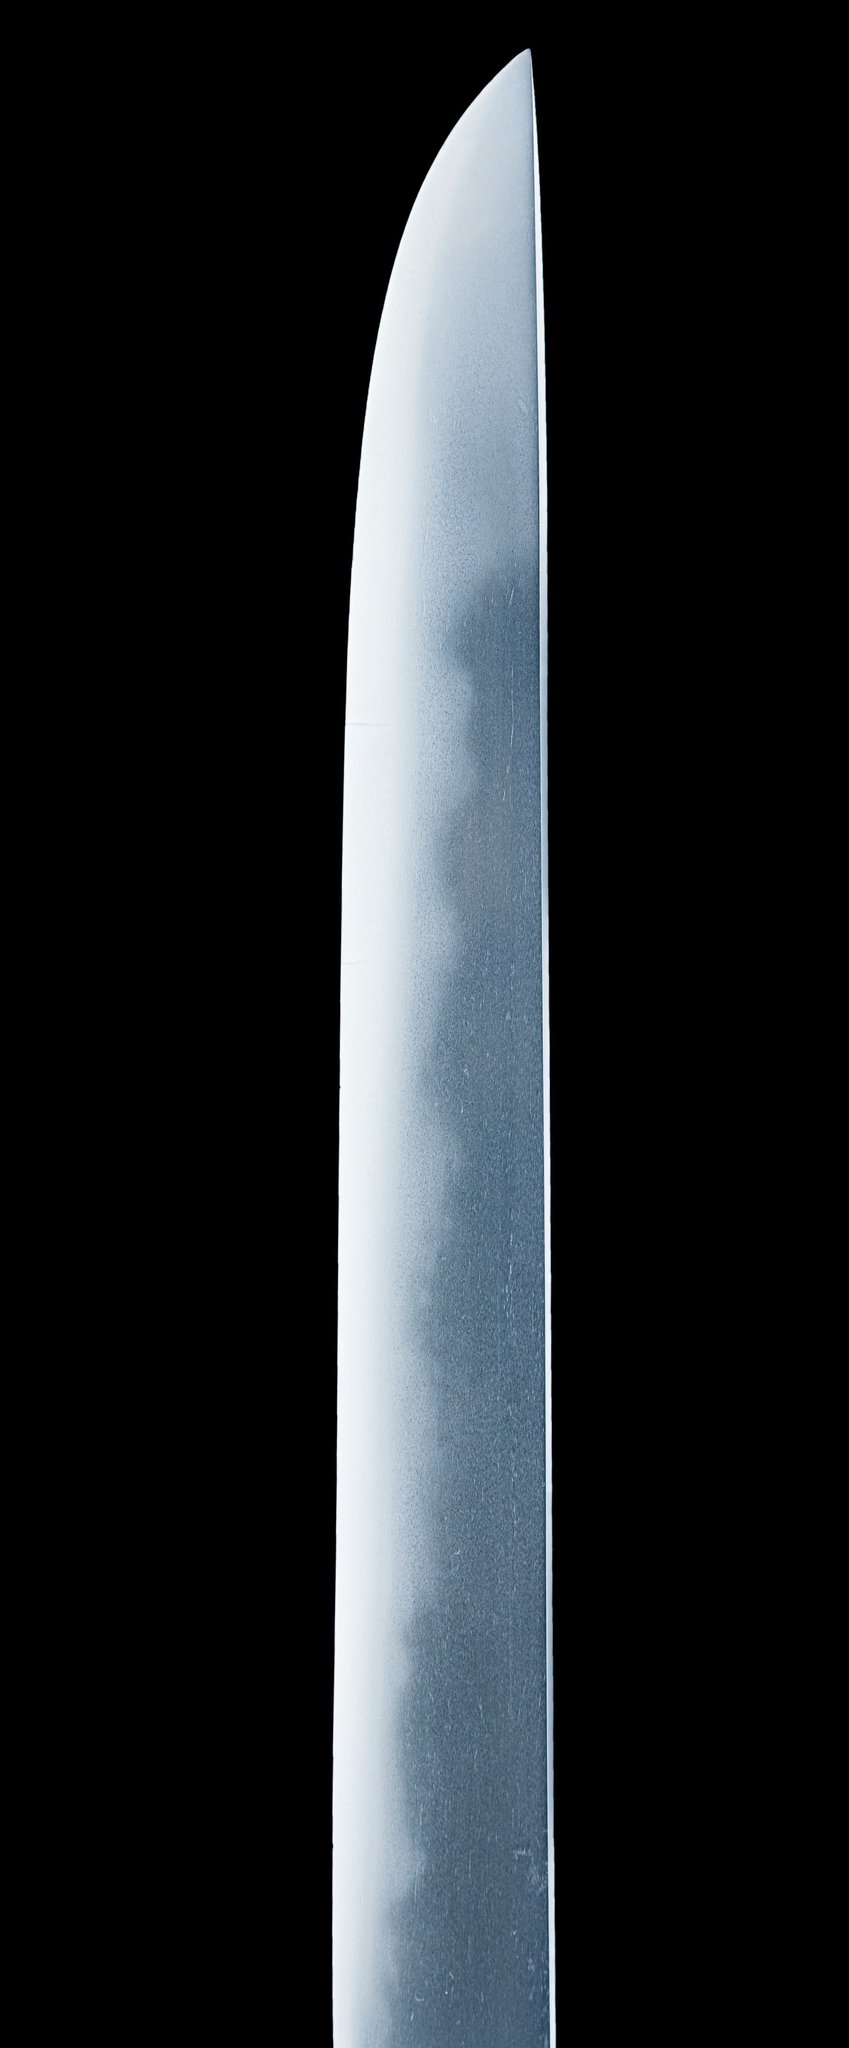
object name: blade and mounting for a dagger tantō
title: Blade and Mounting for a Dagger (Tantō)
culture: japanese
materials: gold, lacquer, silver, steel, thread, wood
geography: japan